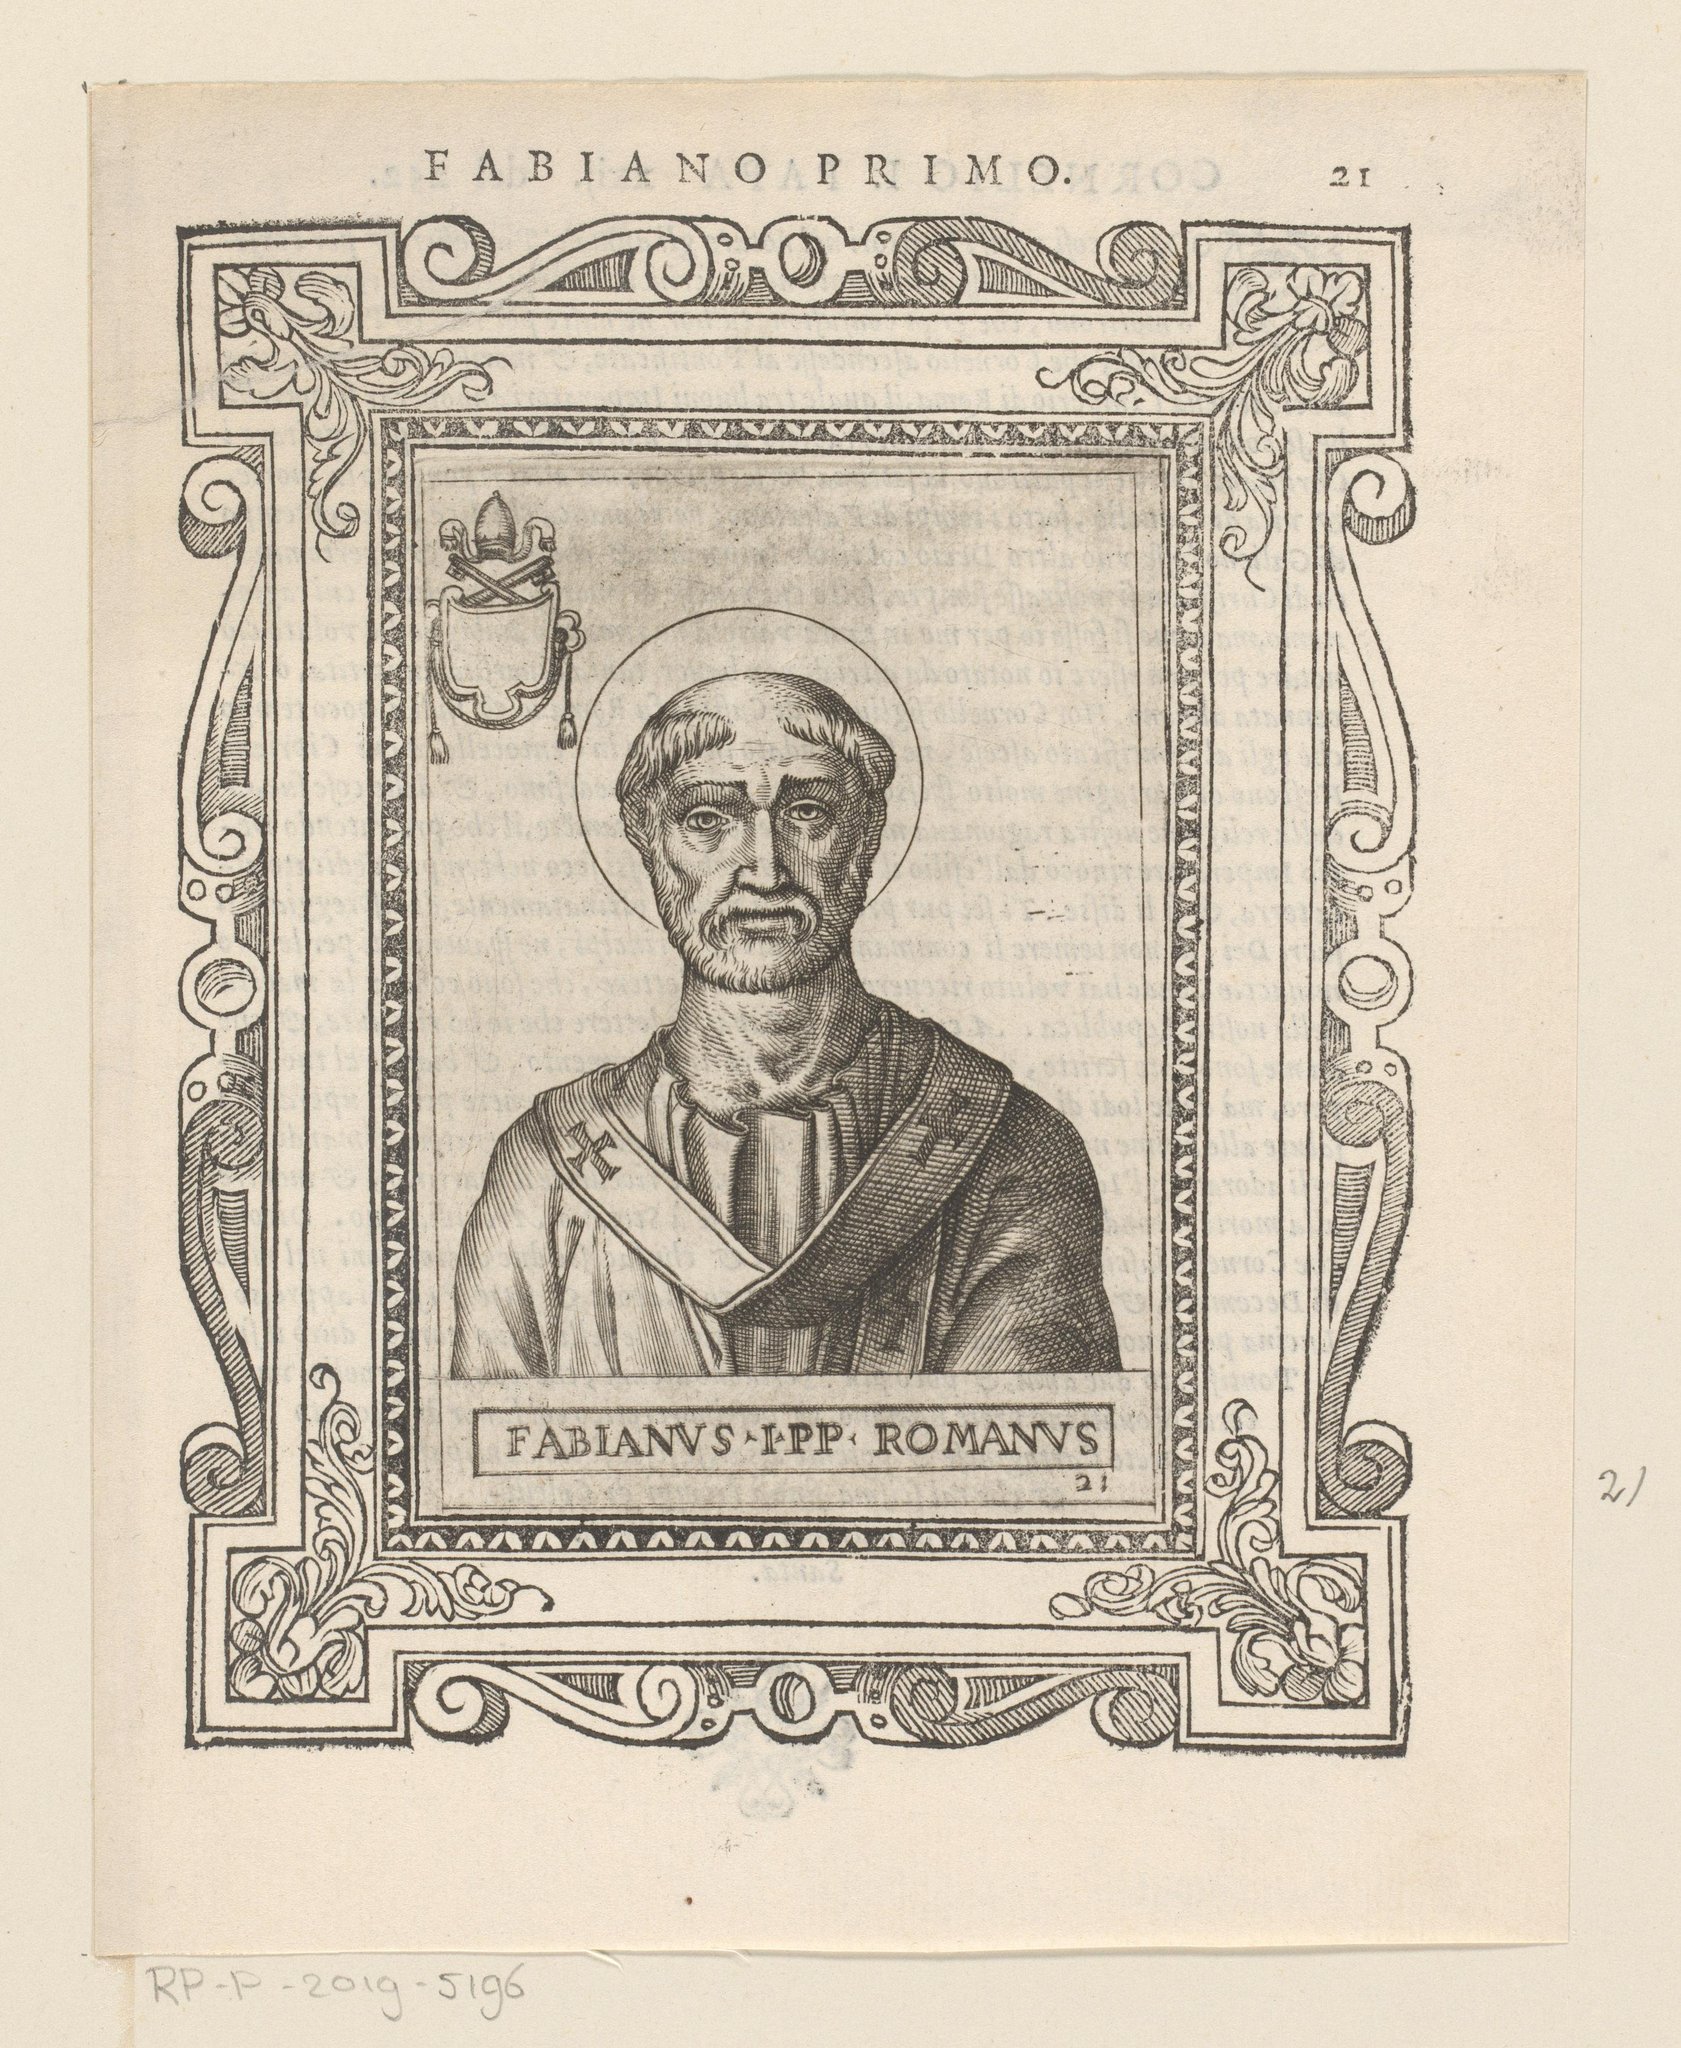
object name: print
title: Portret van paus Fabianus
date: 1587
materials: paper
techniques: engraving, etching, letterpress printing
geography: rome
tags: rome, historical persons, pope, armorial bearing, heraldry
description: Prent uit: Ciccarelli, Antonio. Le vite de Pontefici di Antonio Ciccareli (...). Rome: Dominicus Basa, 1587. Prent ook gebruikt in latere edities.